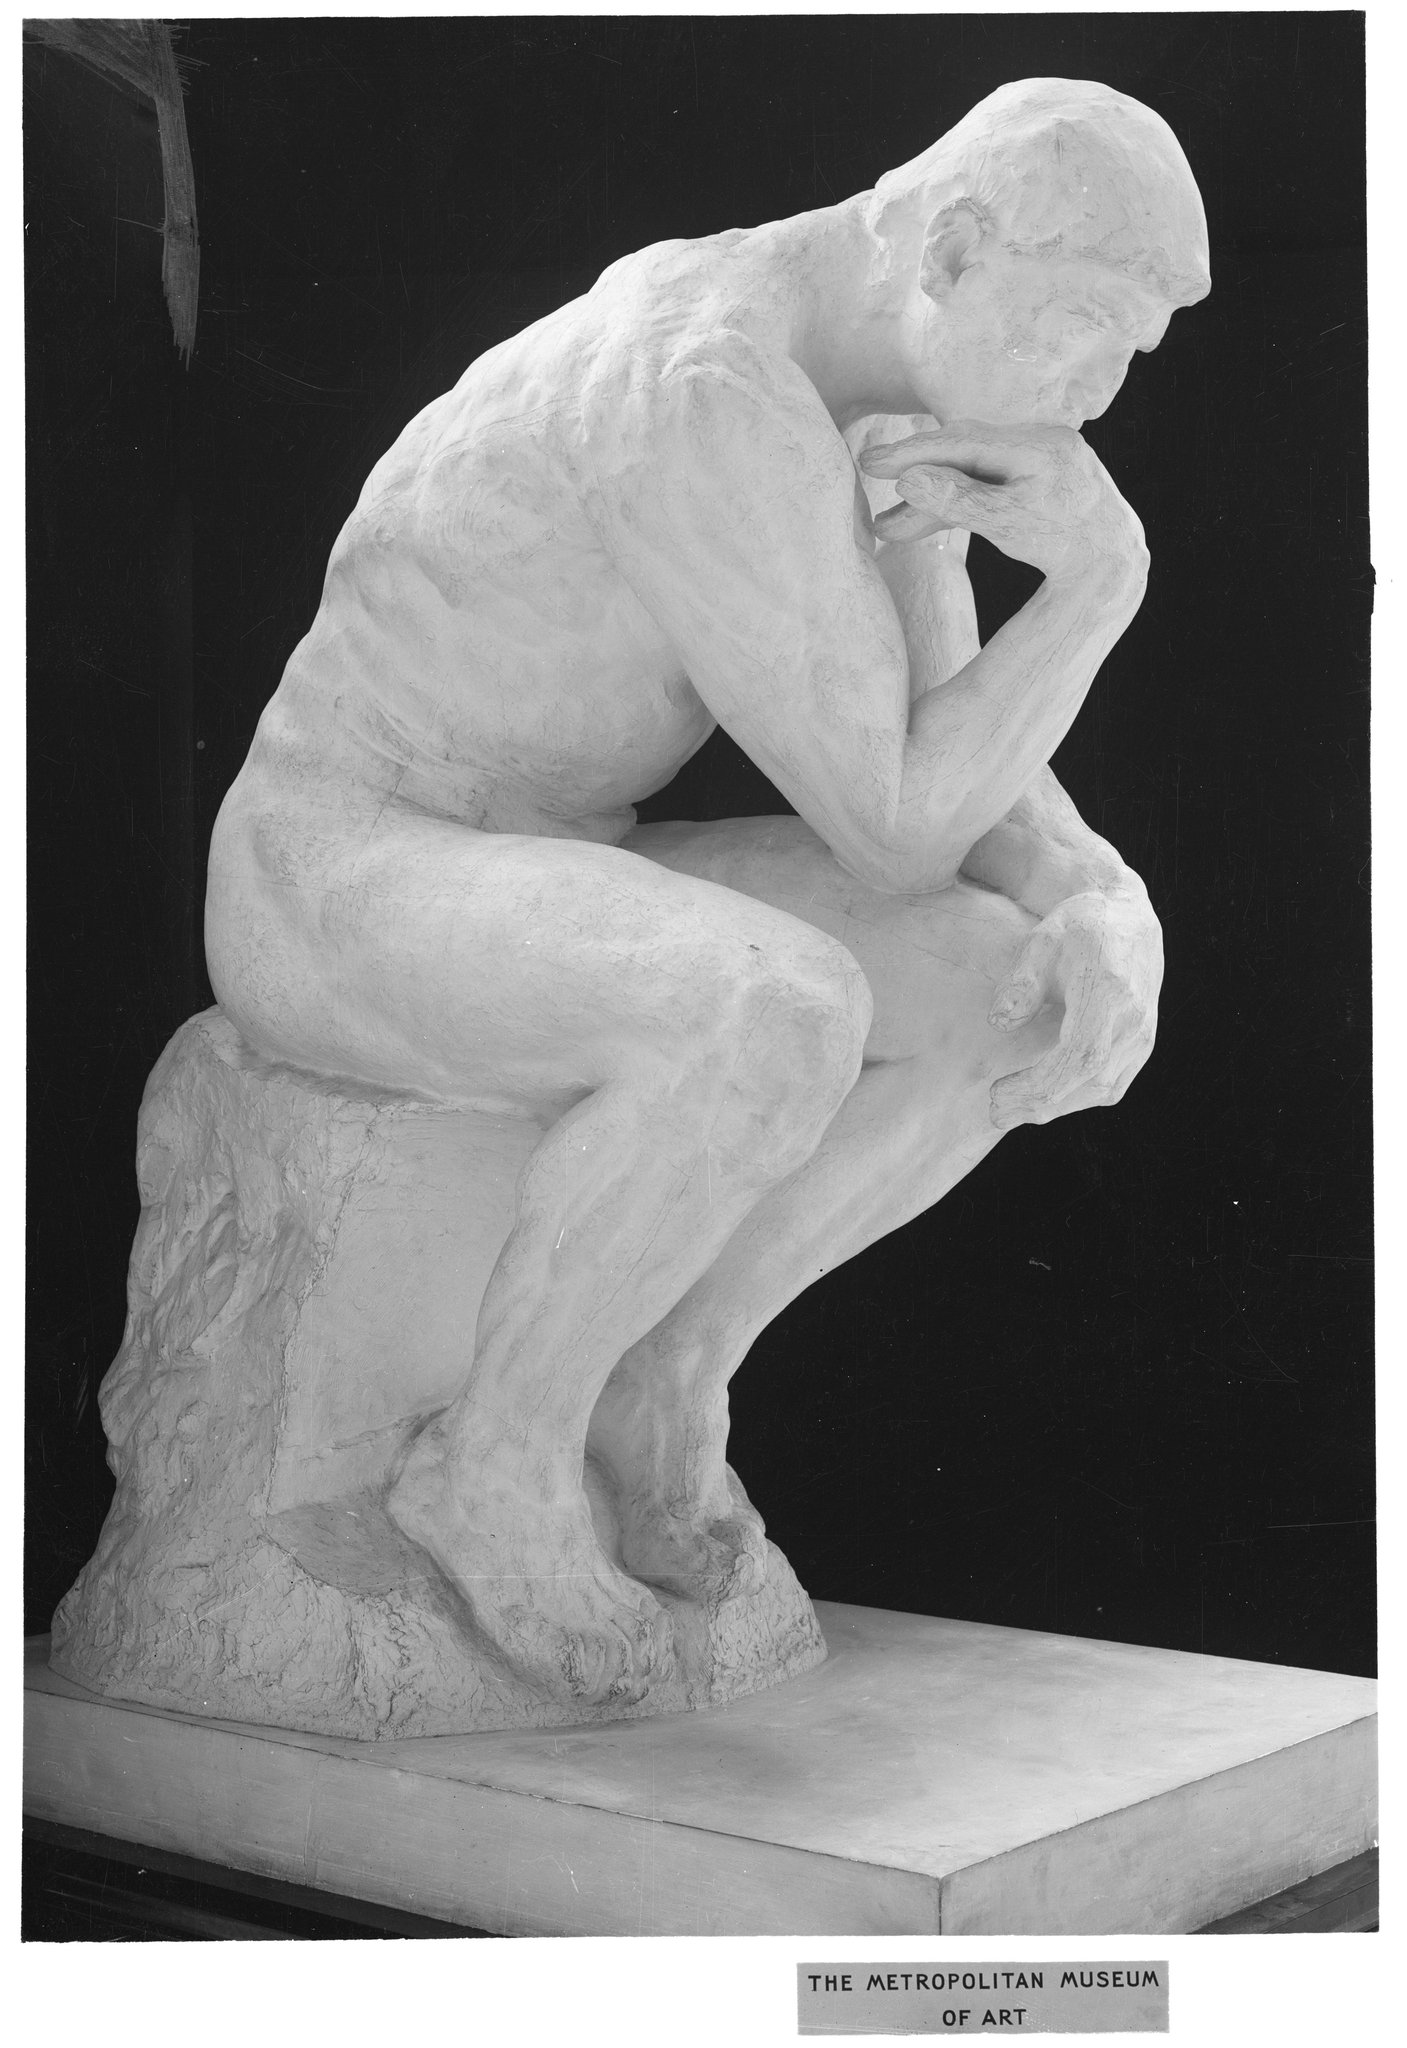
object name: statue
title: The Thinker (Le Penseur)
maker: auguste rodin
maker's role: artist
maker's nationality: french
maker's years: 1840-1917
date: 1904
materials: plaster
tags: contemplation,male nudes